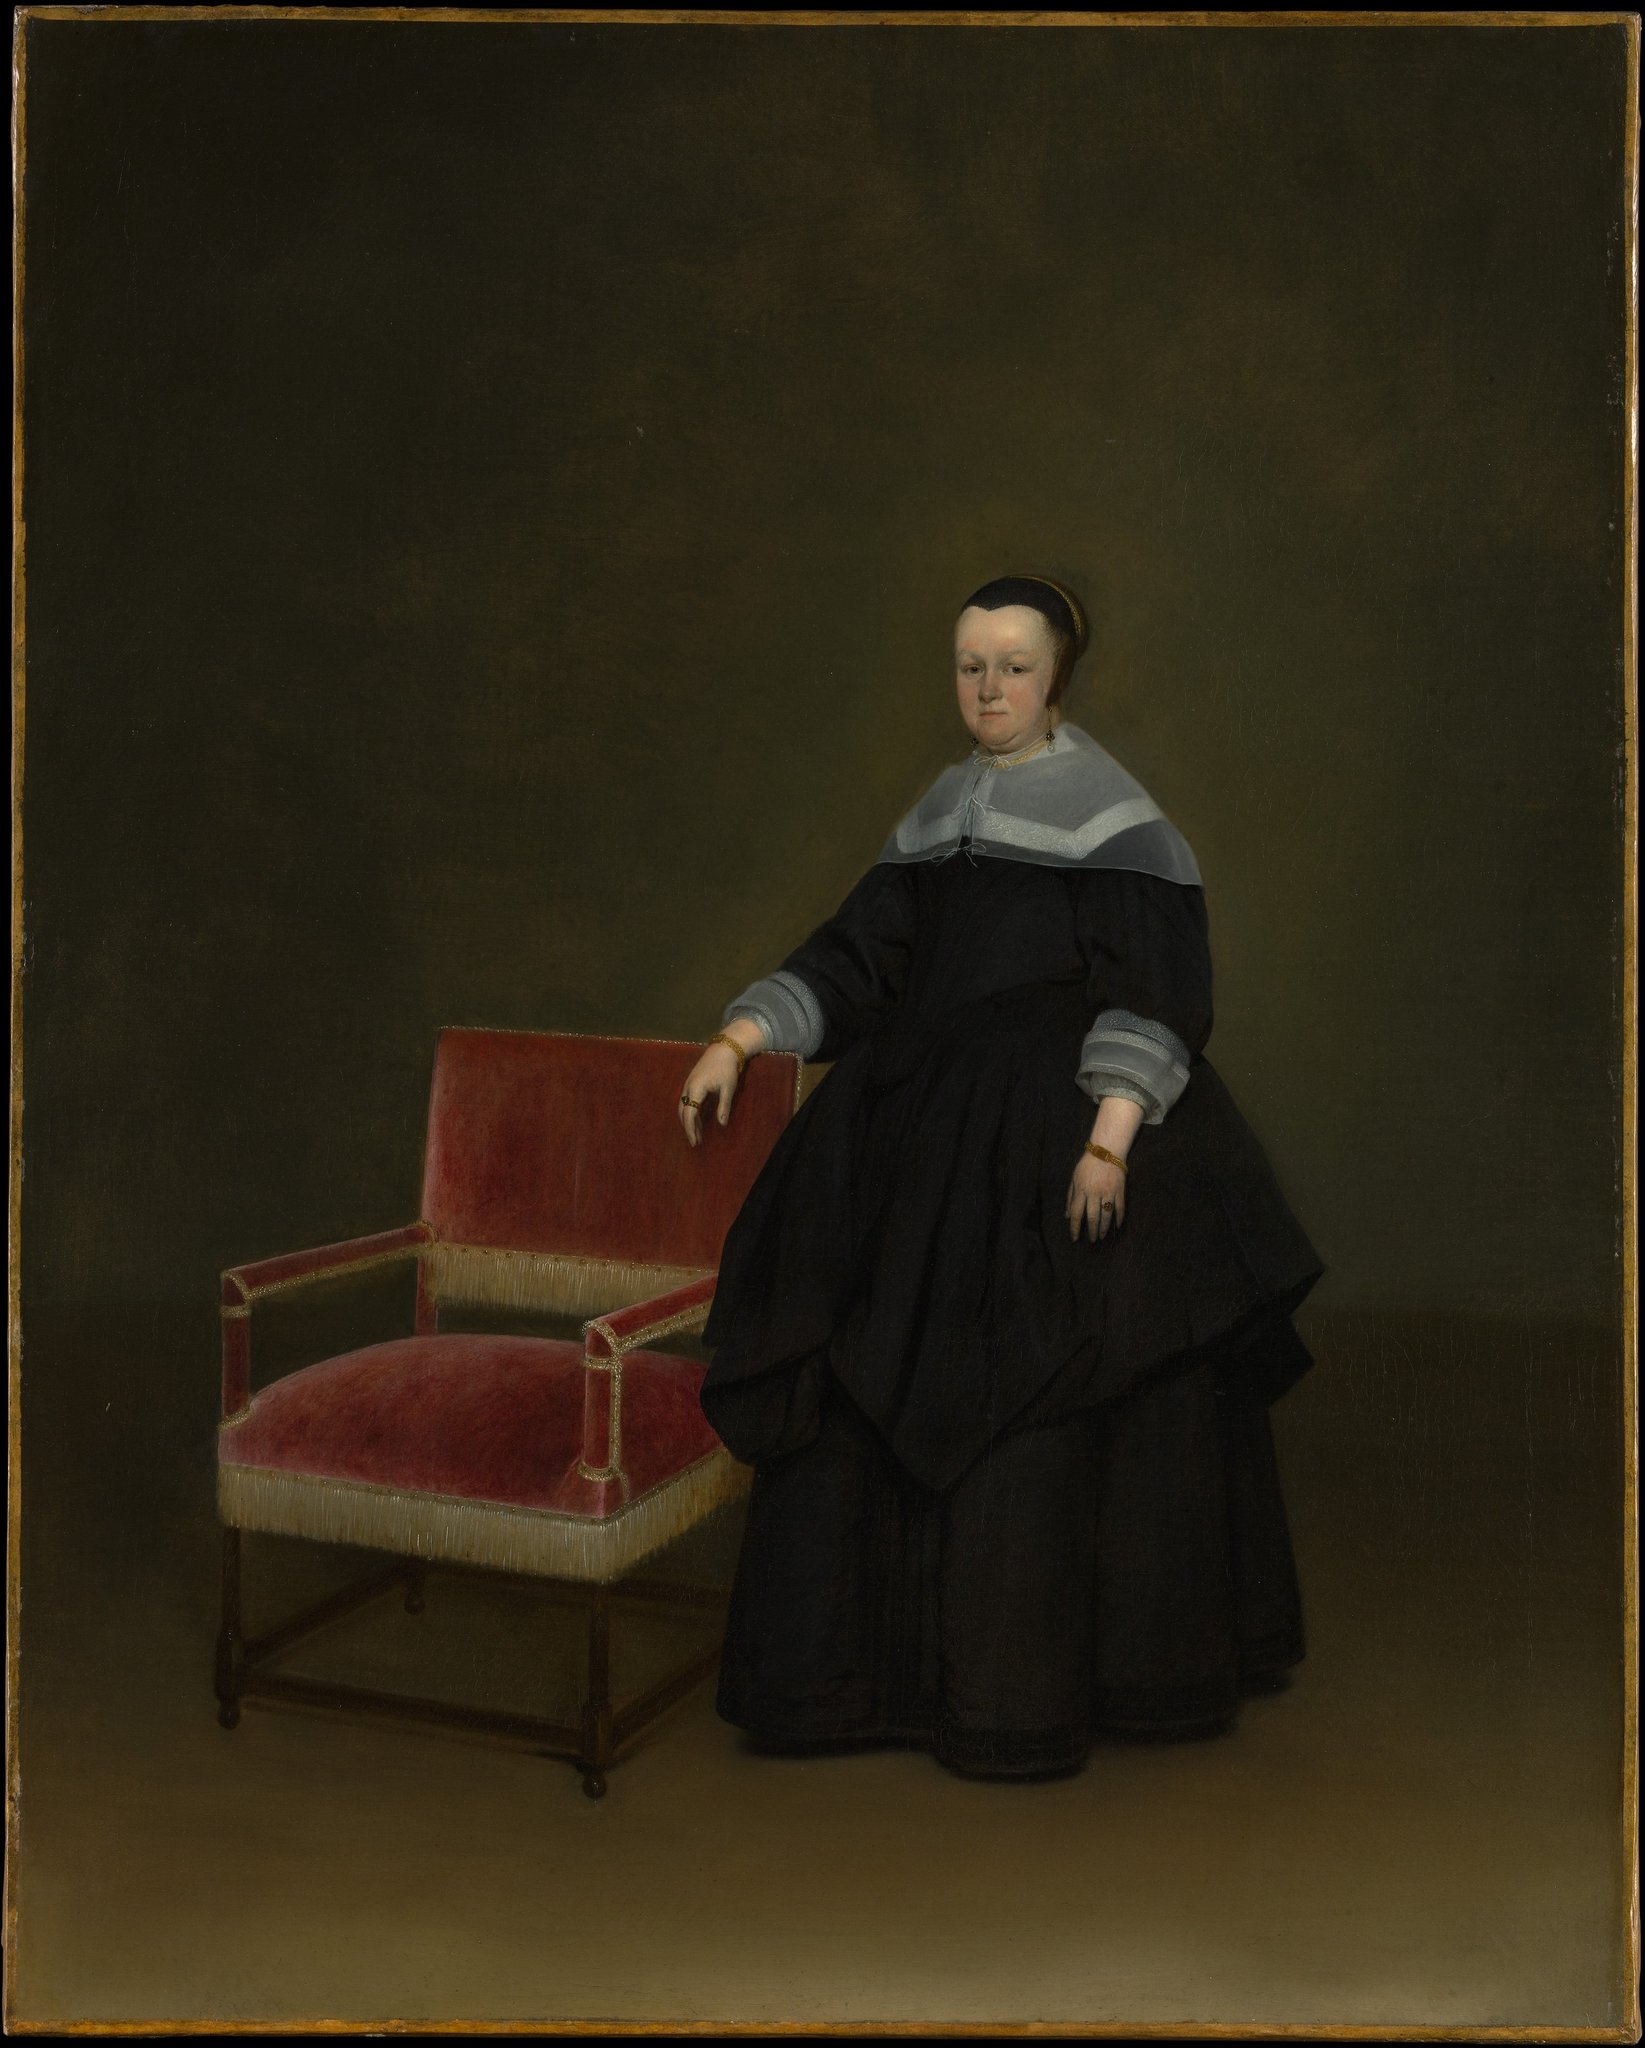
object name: painting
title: Margaretha van Haexbergen (1614–1676)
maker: gerard ter borch the younger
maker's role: artist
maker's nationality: dutch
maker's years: 1617-1681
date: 1666-1667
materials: canvas, oil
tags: portraits,women,chairs